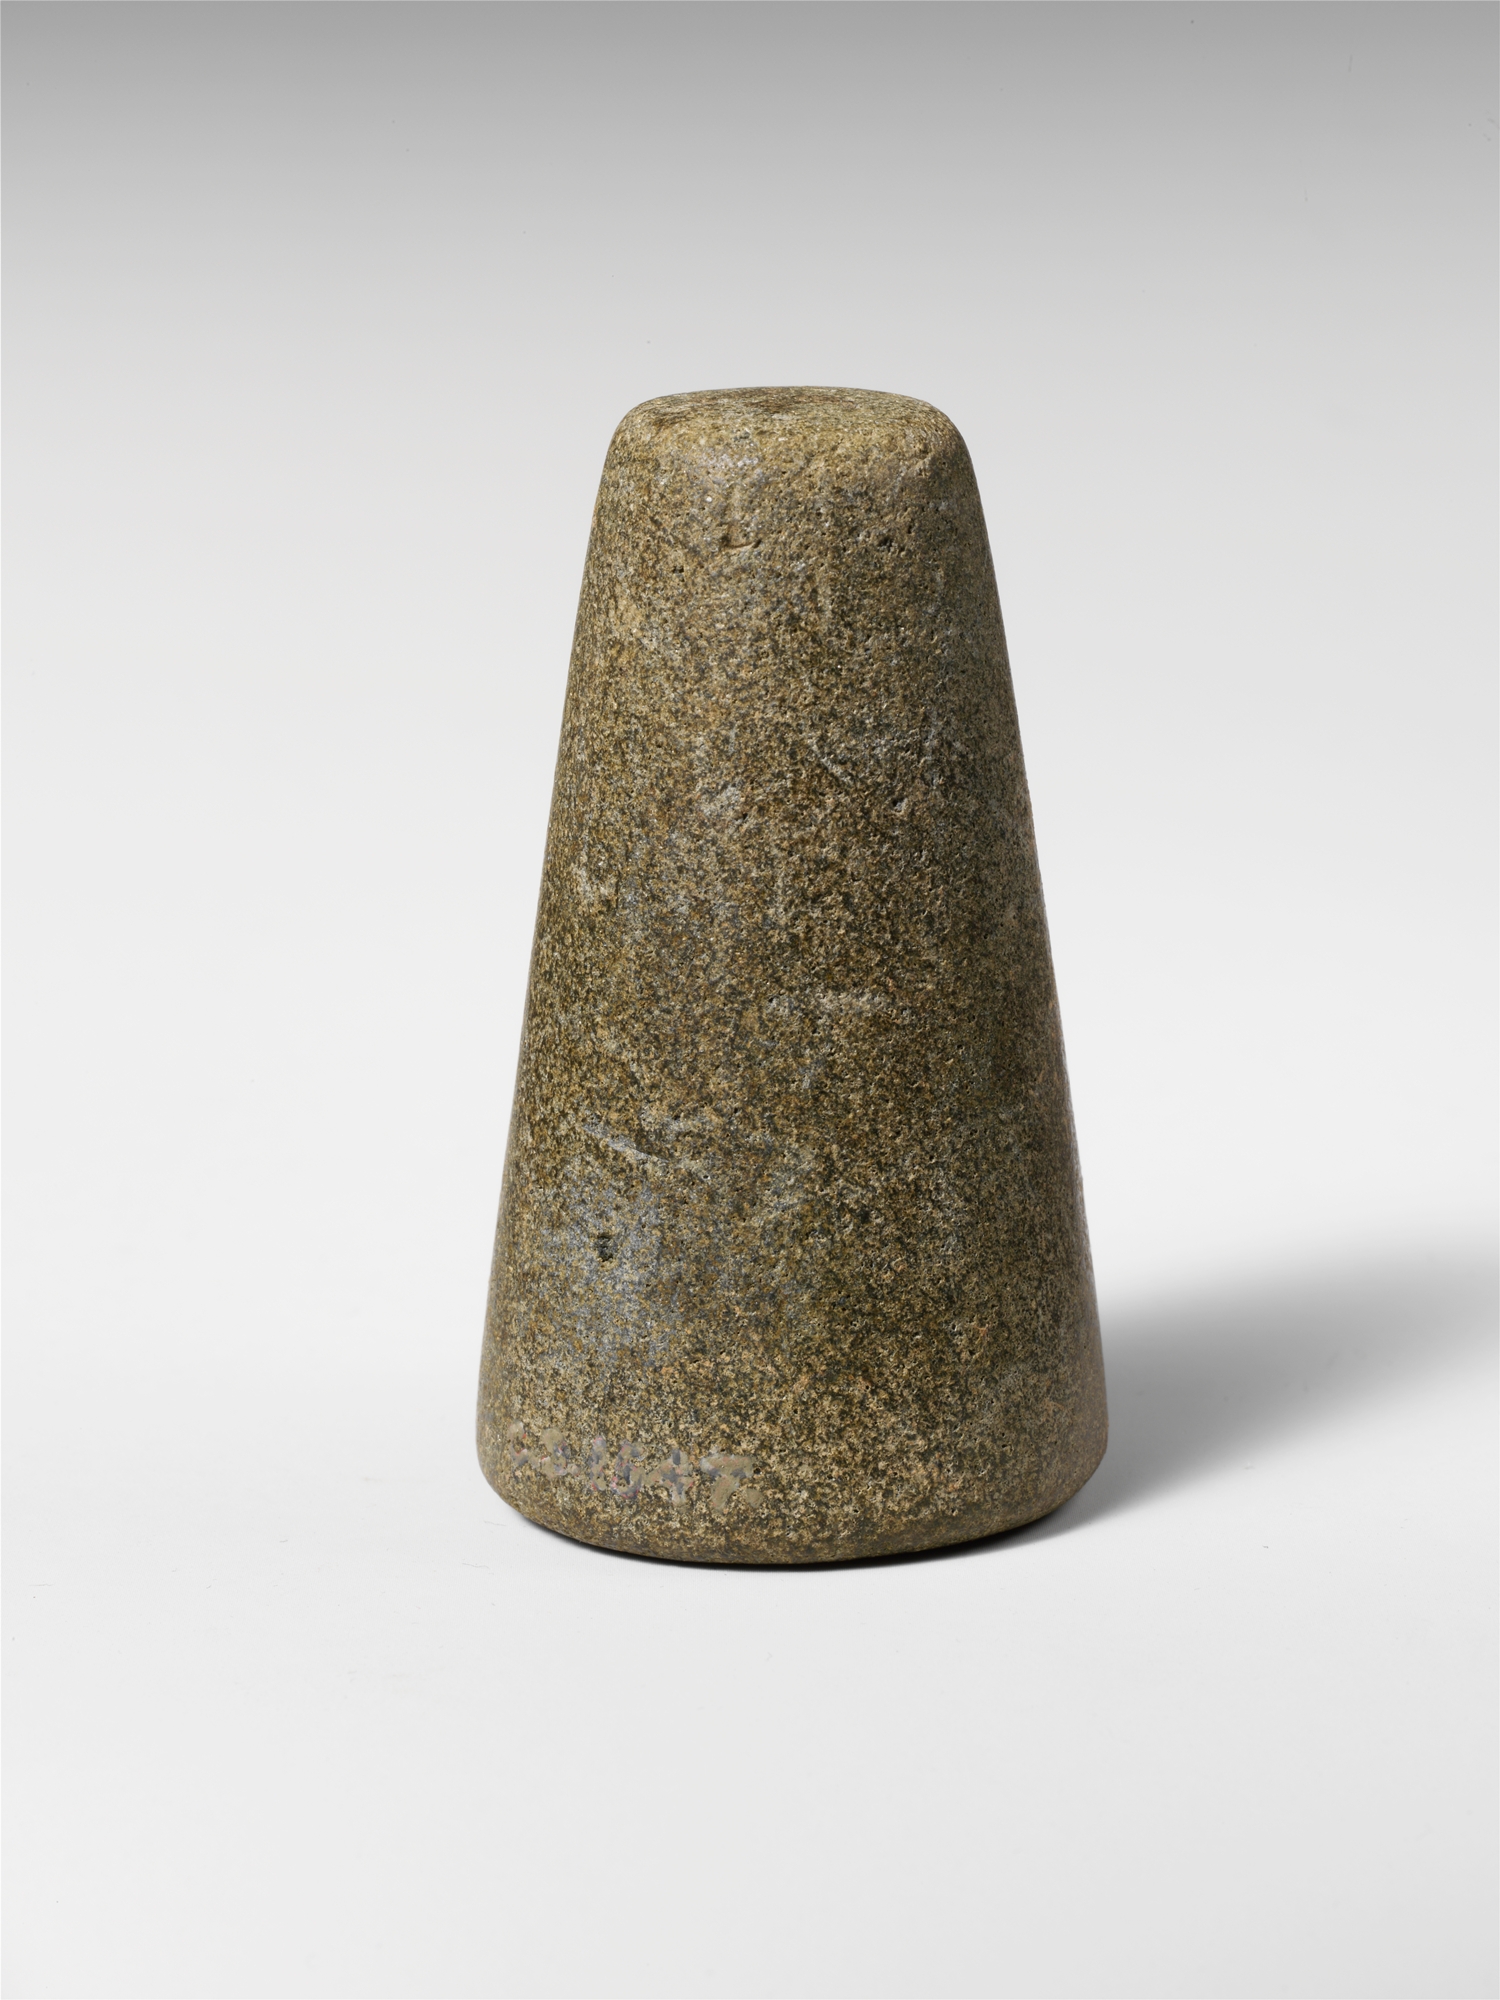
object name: pestle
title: Andesite pestle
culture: cypriot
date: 1600-1100 BCE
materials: stone